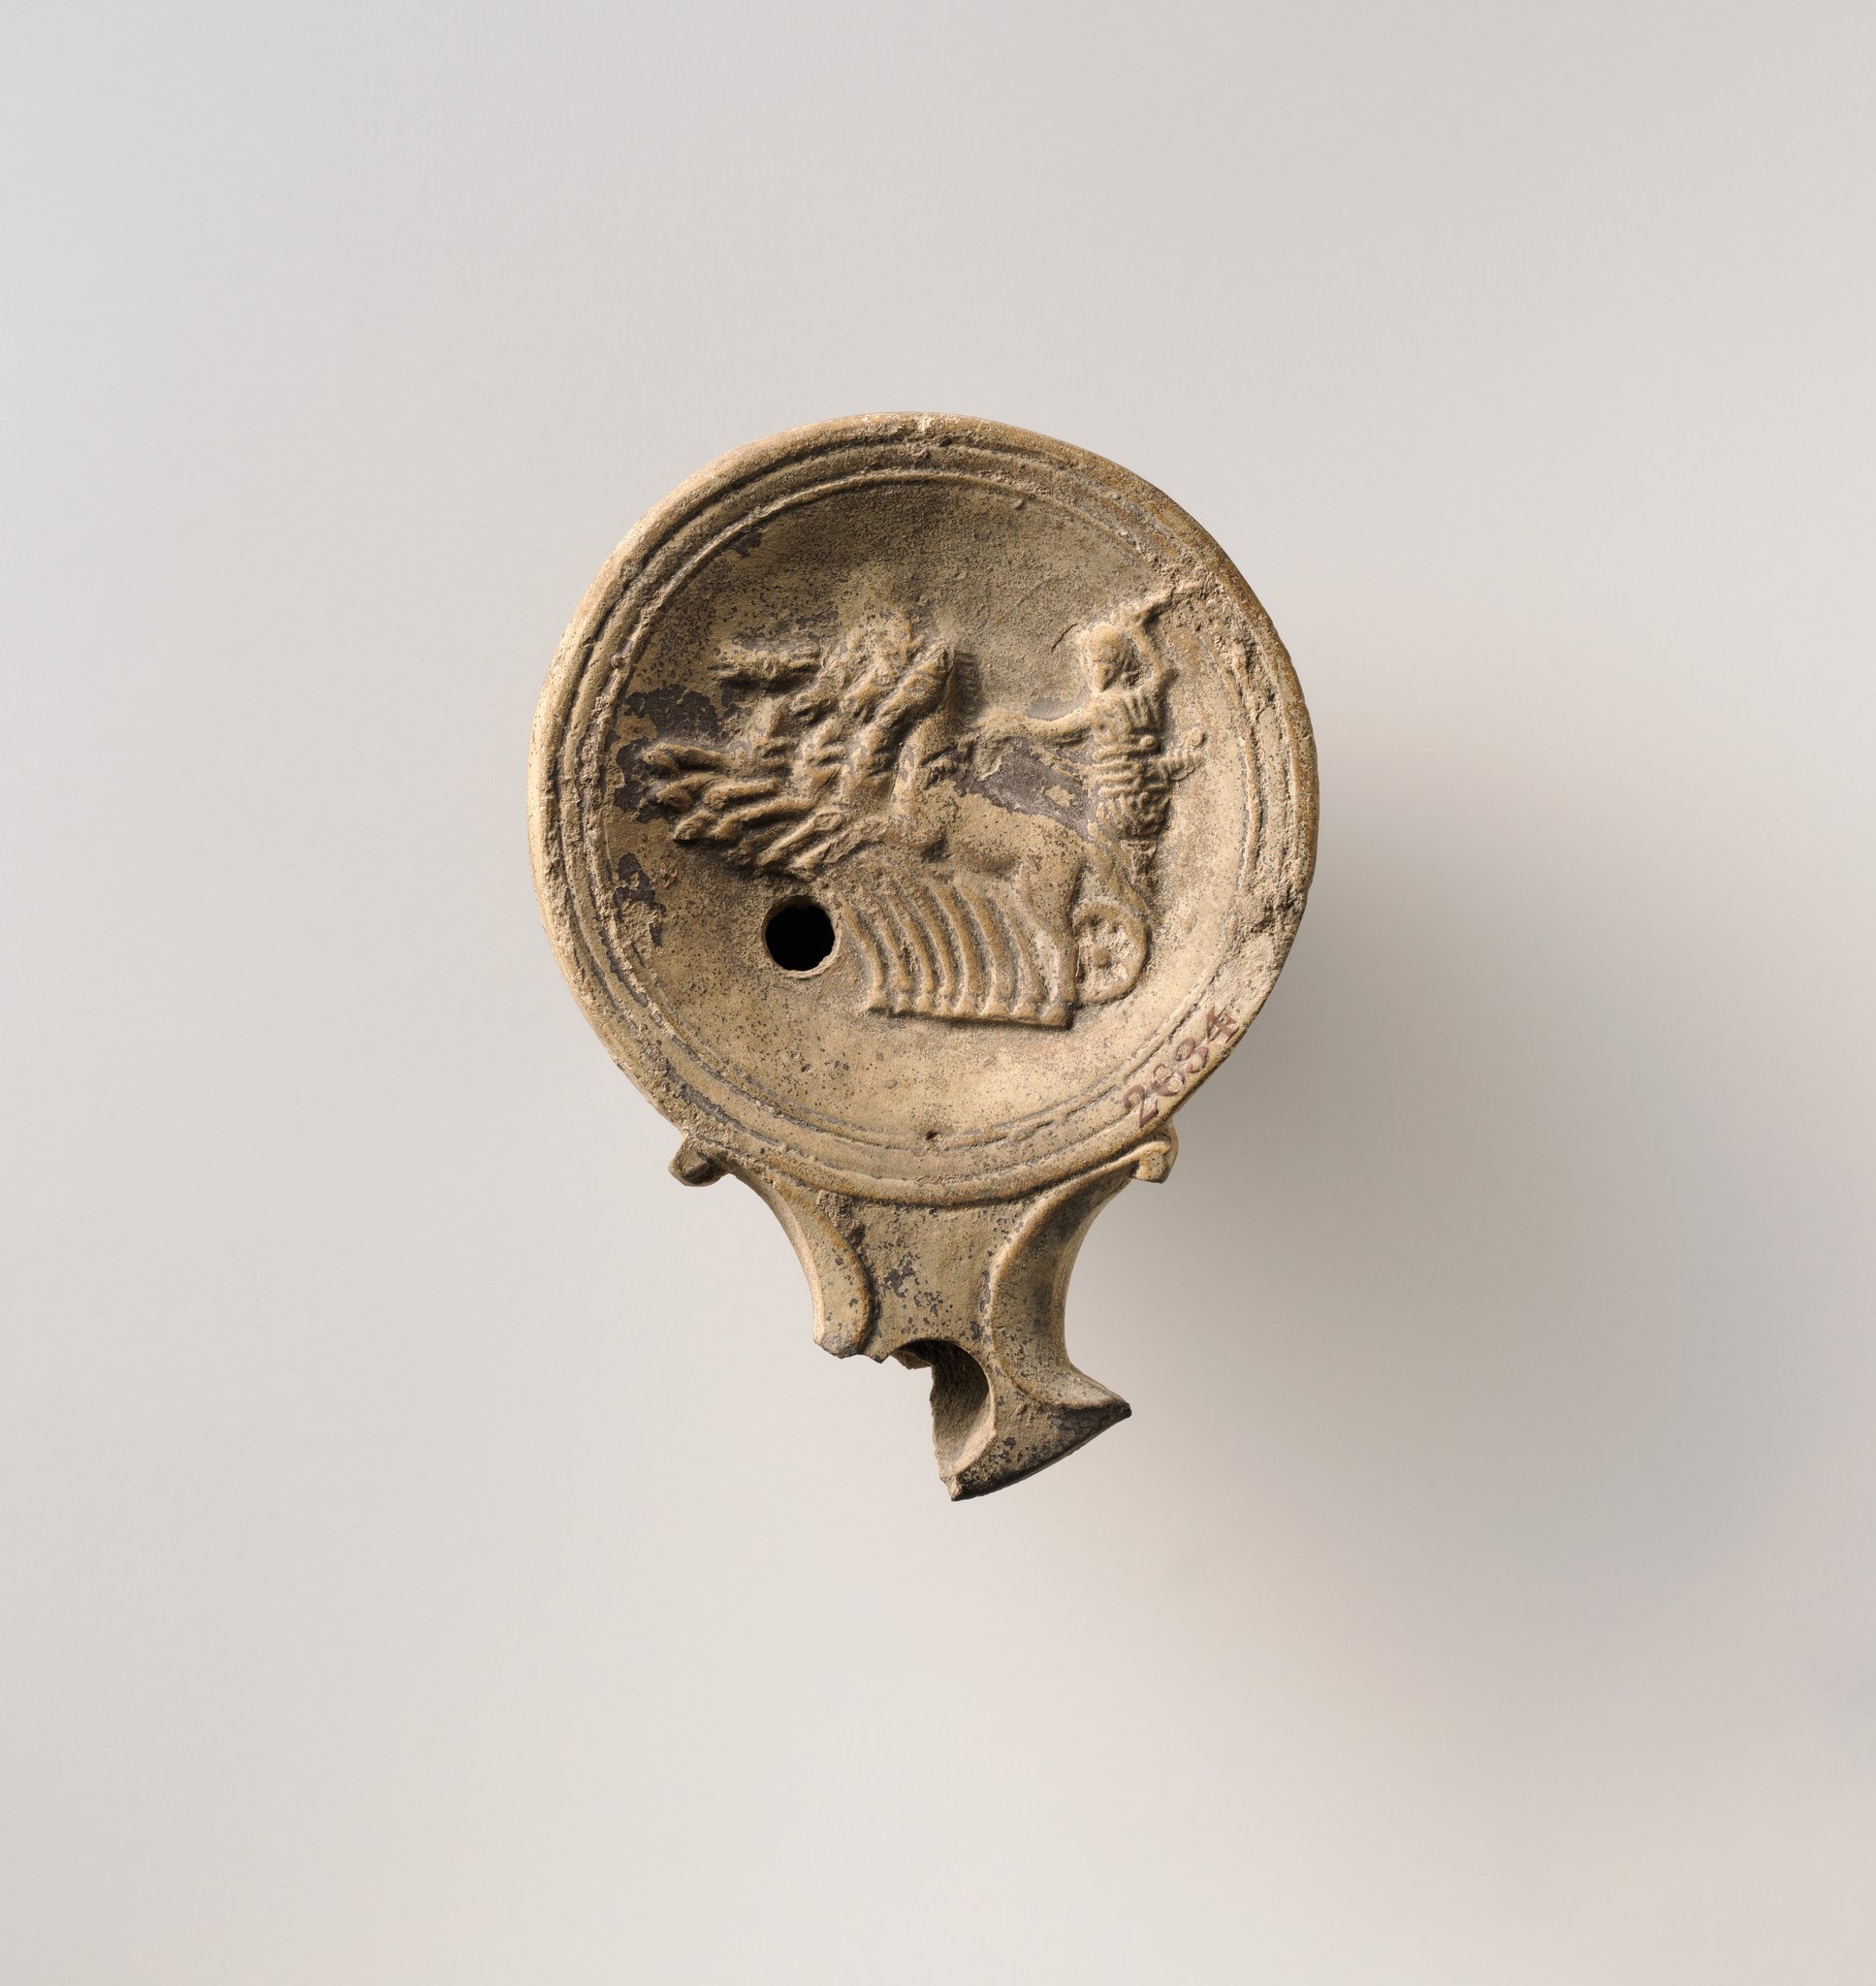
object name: lamp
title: Terracotta oil lamp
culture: roman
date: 1-50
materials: terracotta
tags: horses,chariots